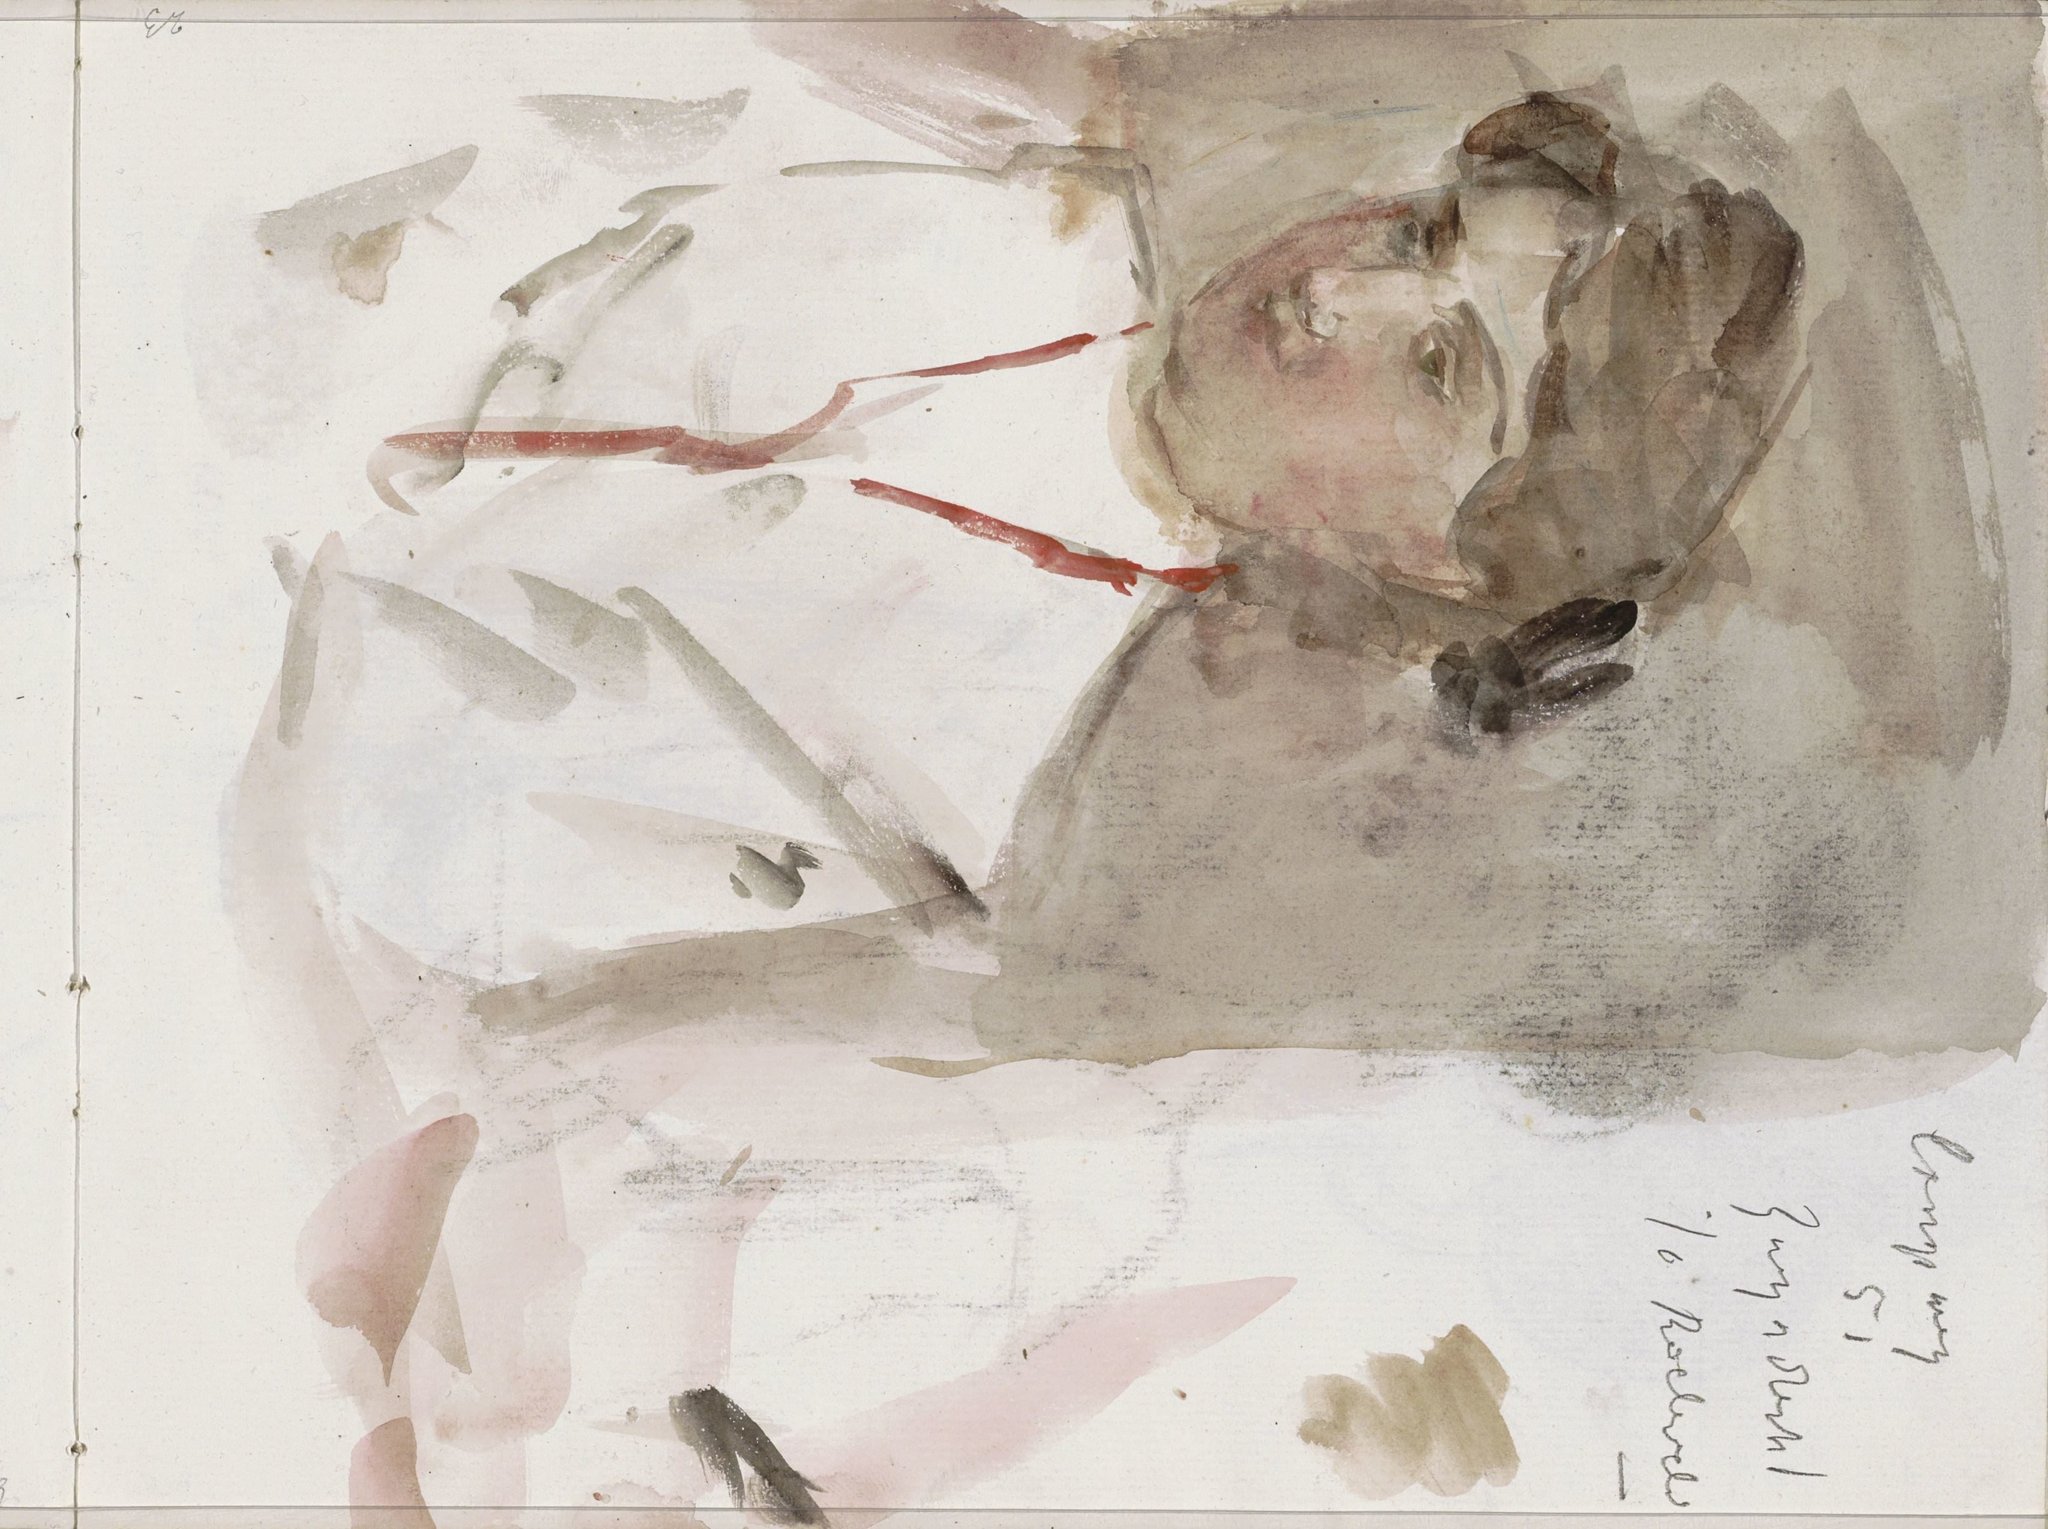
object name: sketchbook leaf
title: Vrouw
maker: isaac israels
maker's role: draughtsman, painter, print maker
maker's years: 1865-1934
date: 1875-1934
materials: paper, watercolor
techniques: brush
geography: the hague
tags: adult woman (+ front view)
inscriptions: annotation: ‘lange weg / 51 / [...] / t/o Roeleveld’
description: Blad 9 recto uit schetsboek XXII met 30 bladen.